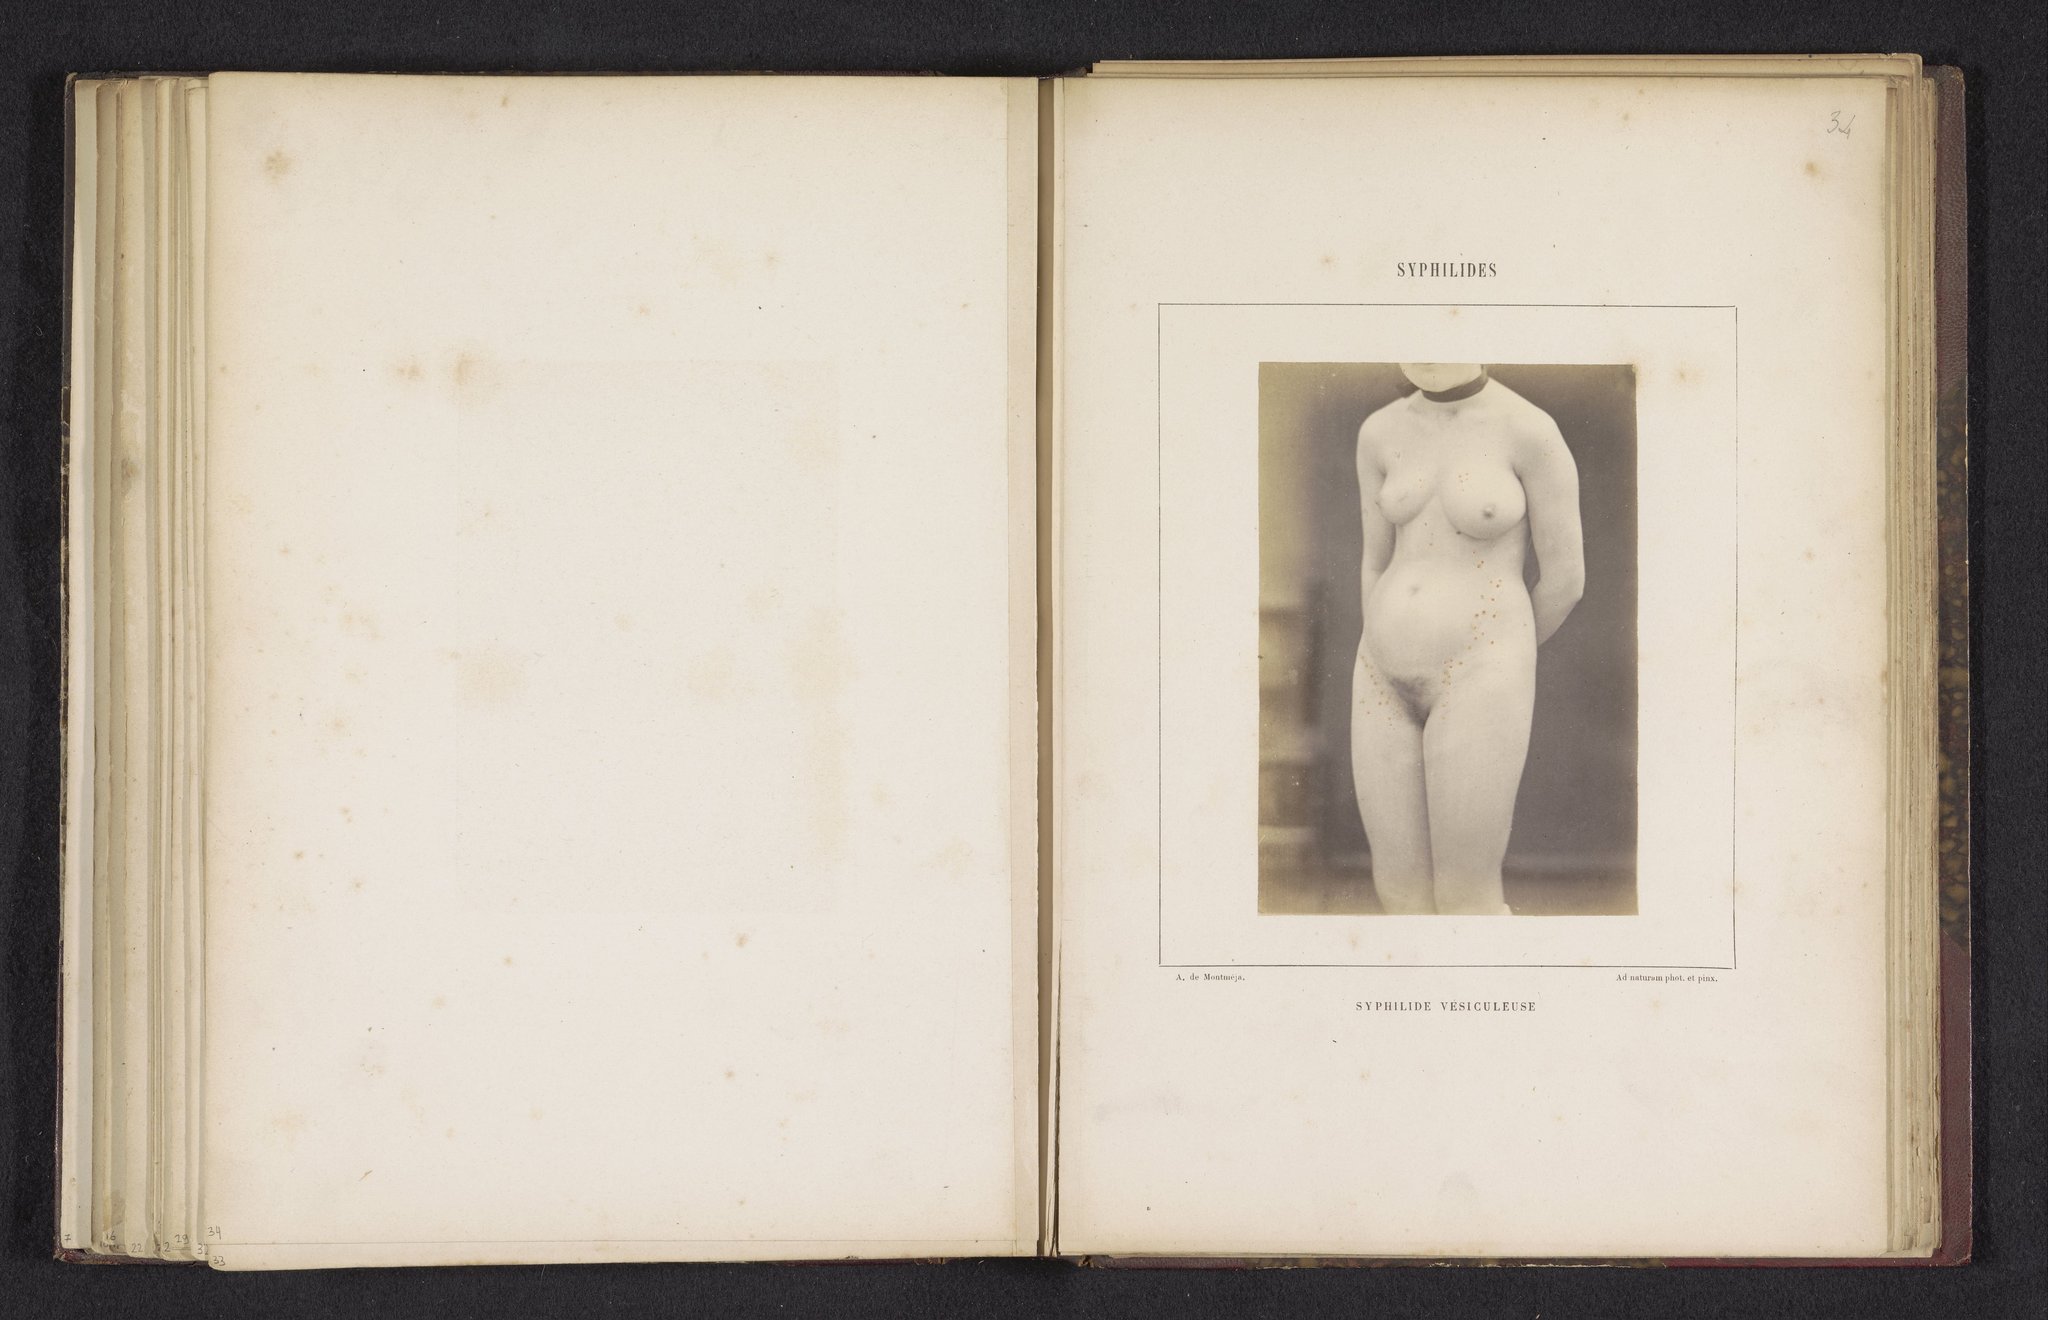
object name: photograph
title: Syphilide vésiculeuse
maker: a. de montméja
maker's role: arts, fotograaf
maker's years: 1841-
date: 1860-1868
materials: photographic support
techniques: albumen print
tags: skin and venereal diseases: syphilis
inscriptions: inscription: ‘Ad naturam phot. et pinx.’, number: ‘34’, inscription: ‘Syphilides’